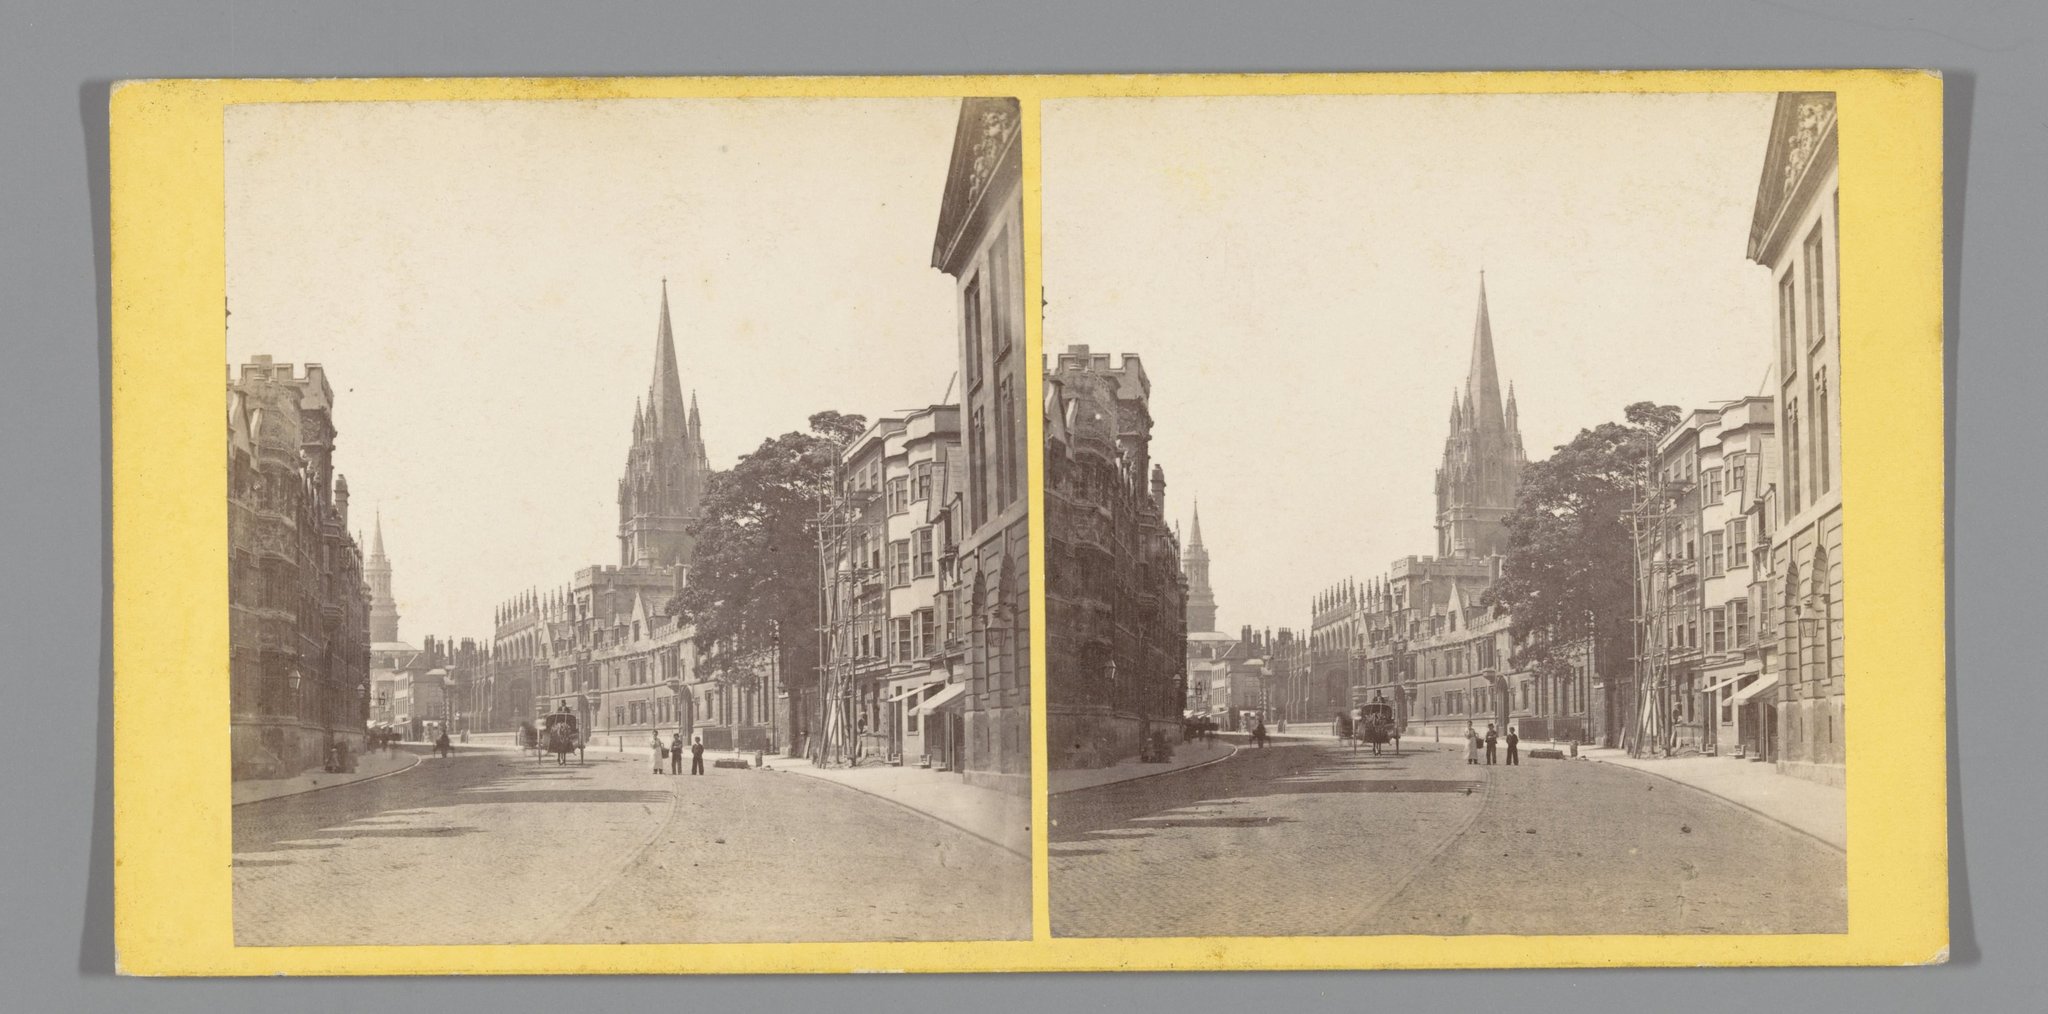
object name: stereograph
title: Gezicht op High Street te Oxford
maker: alexander wilson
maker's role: fotograaf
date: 1850-1880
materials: cardboard, photographic support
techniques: albumen print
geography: oxford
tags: street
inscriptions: number: ‘No. 202.’, name: ‘Alexander Wilson, Photographer, Leamington.’